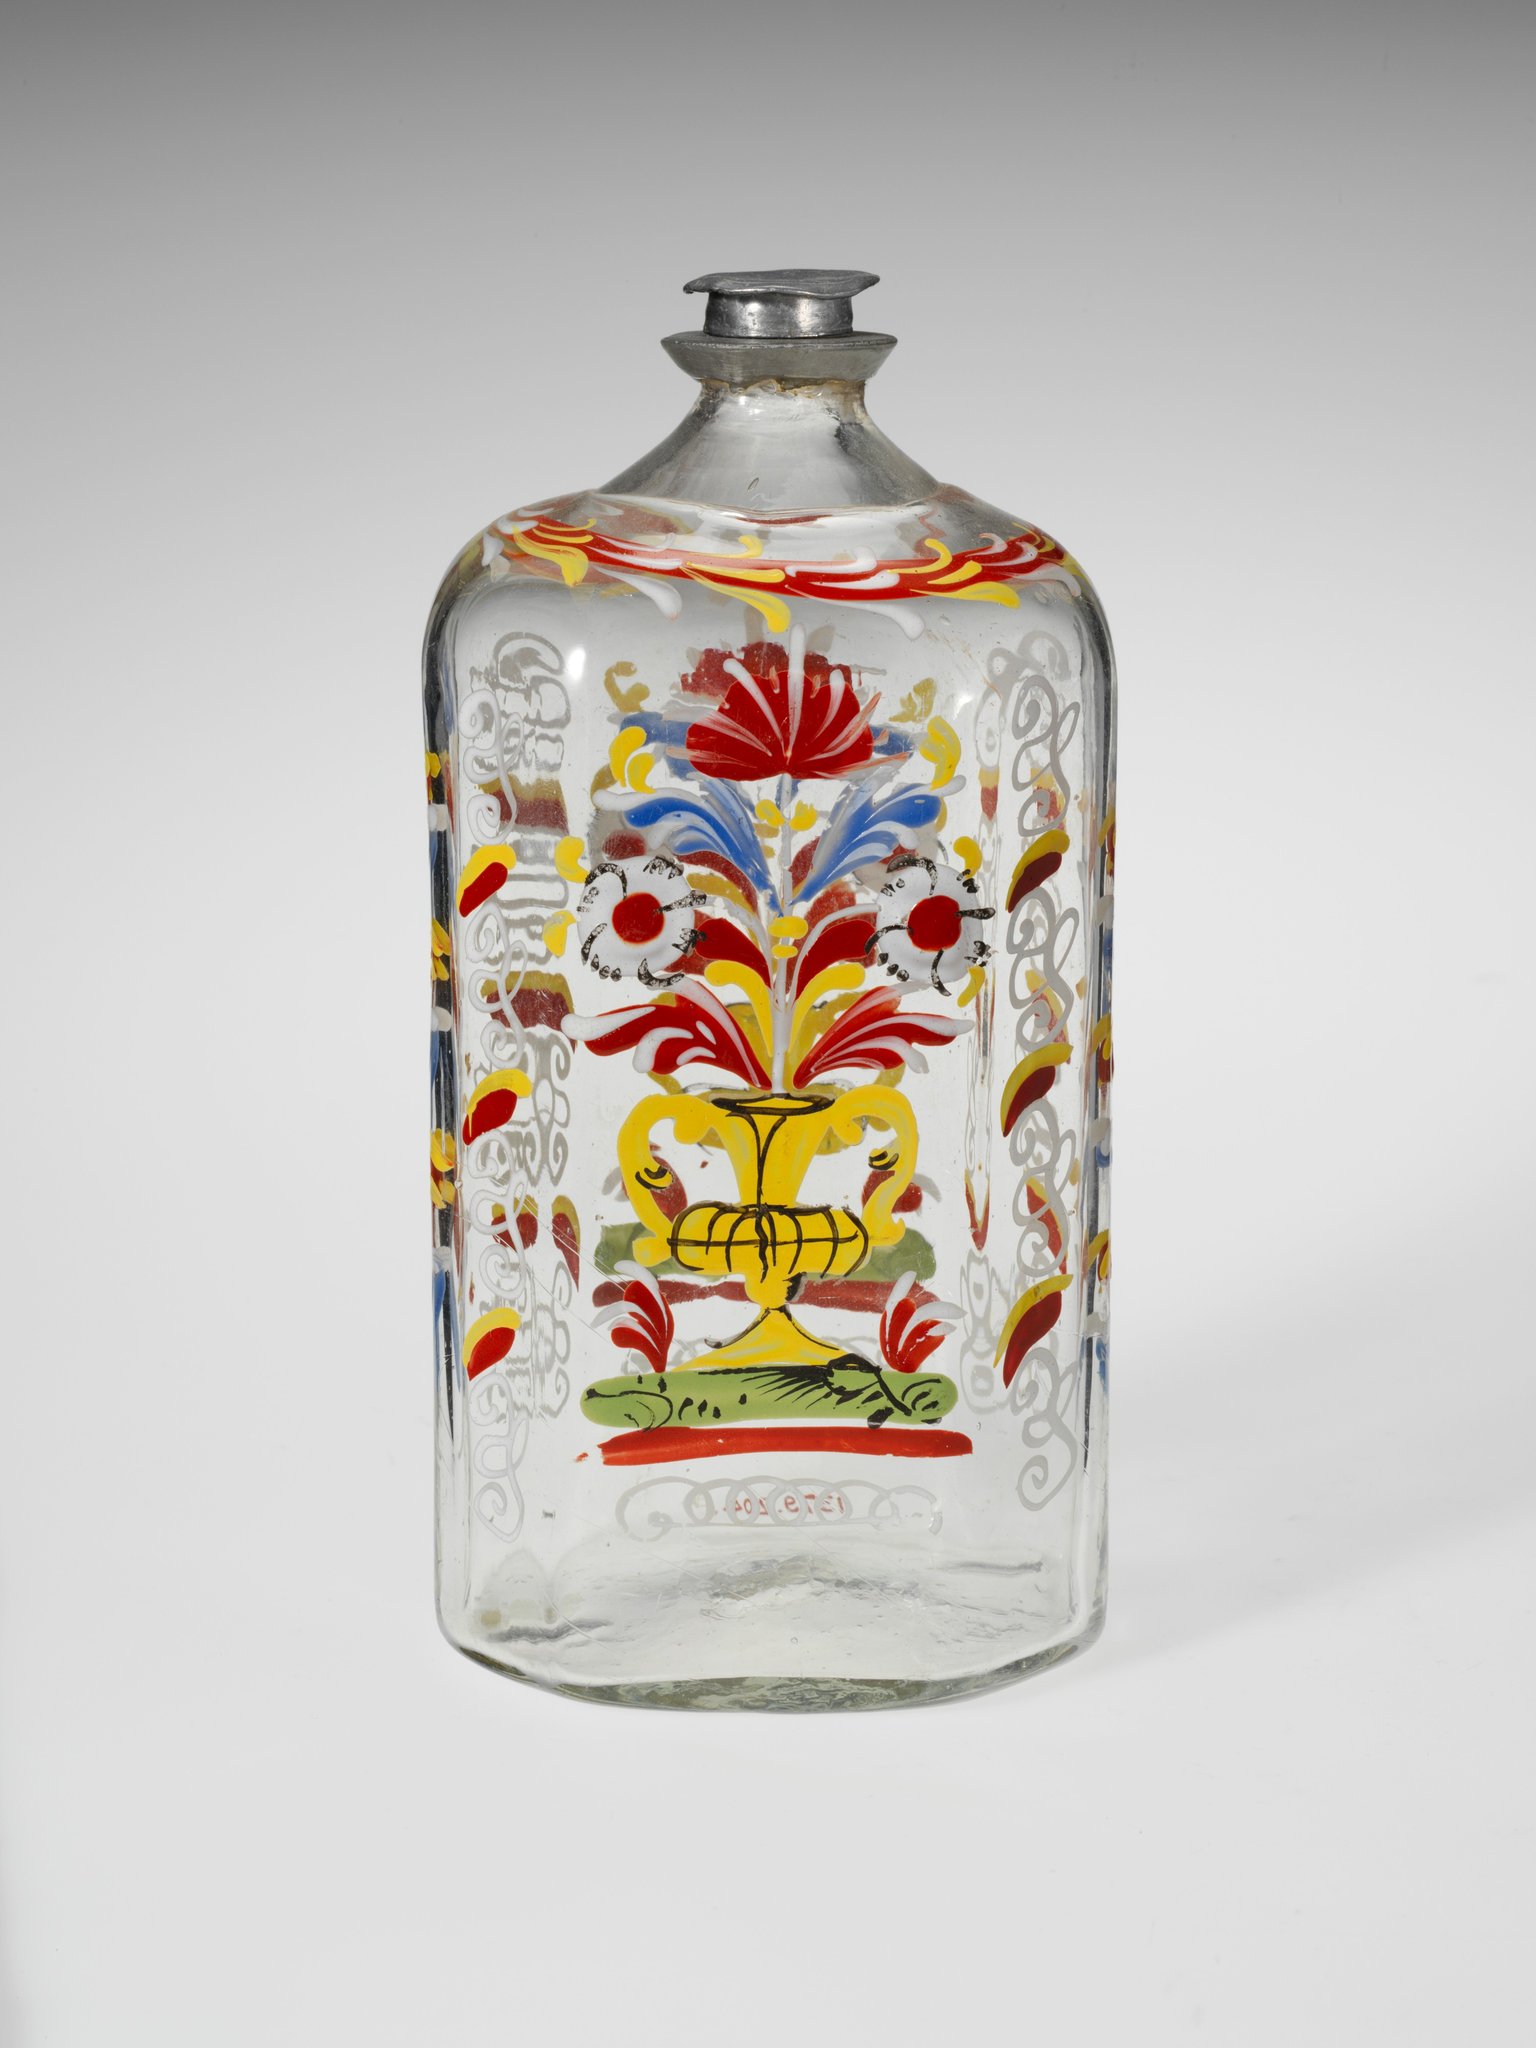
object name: bottle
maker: sebastian witmer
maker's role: maker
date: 1763-1774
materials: enamel, glass, lead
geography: czech republic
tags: flowers